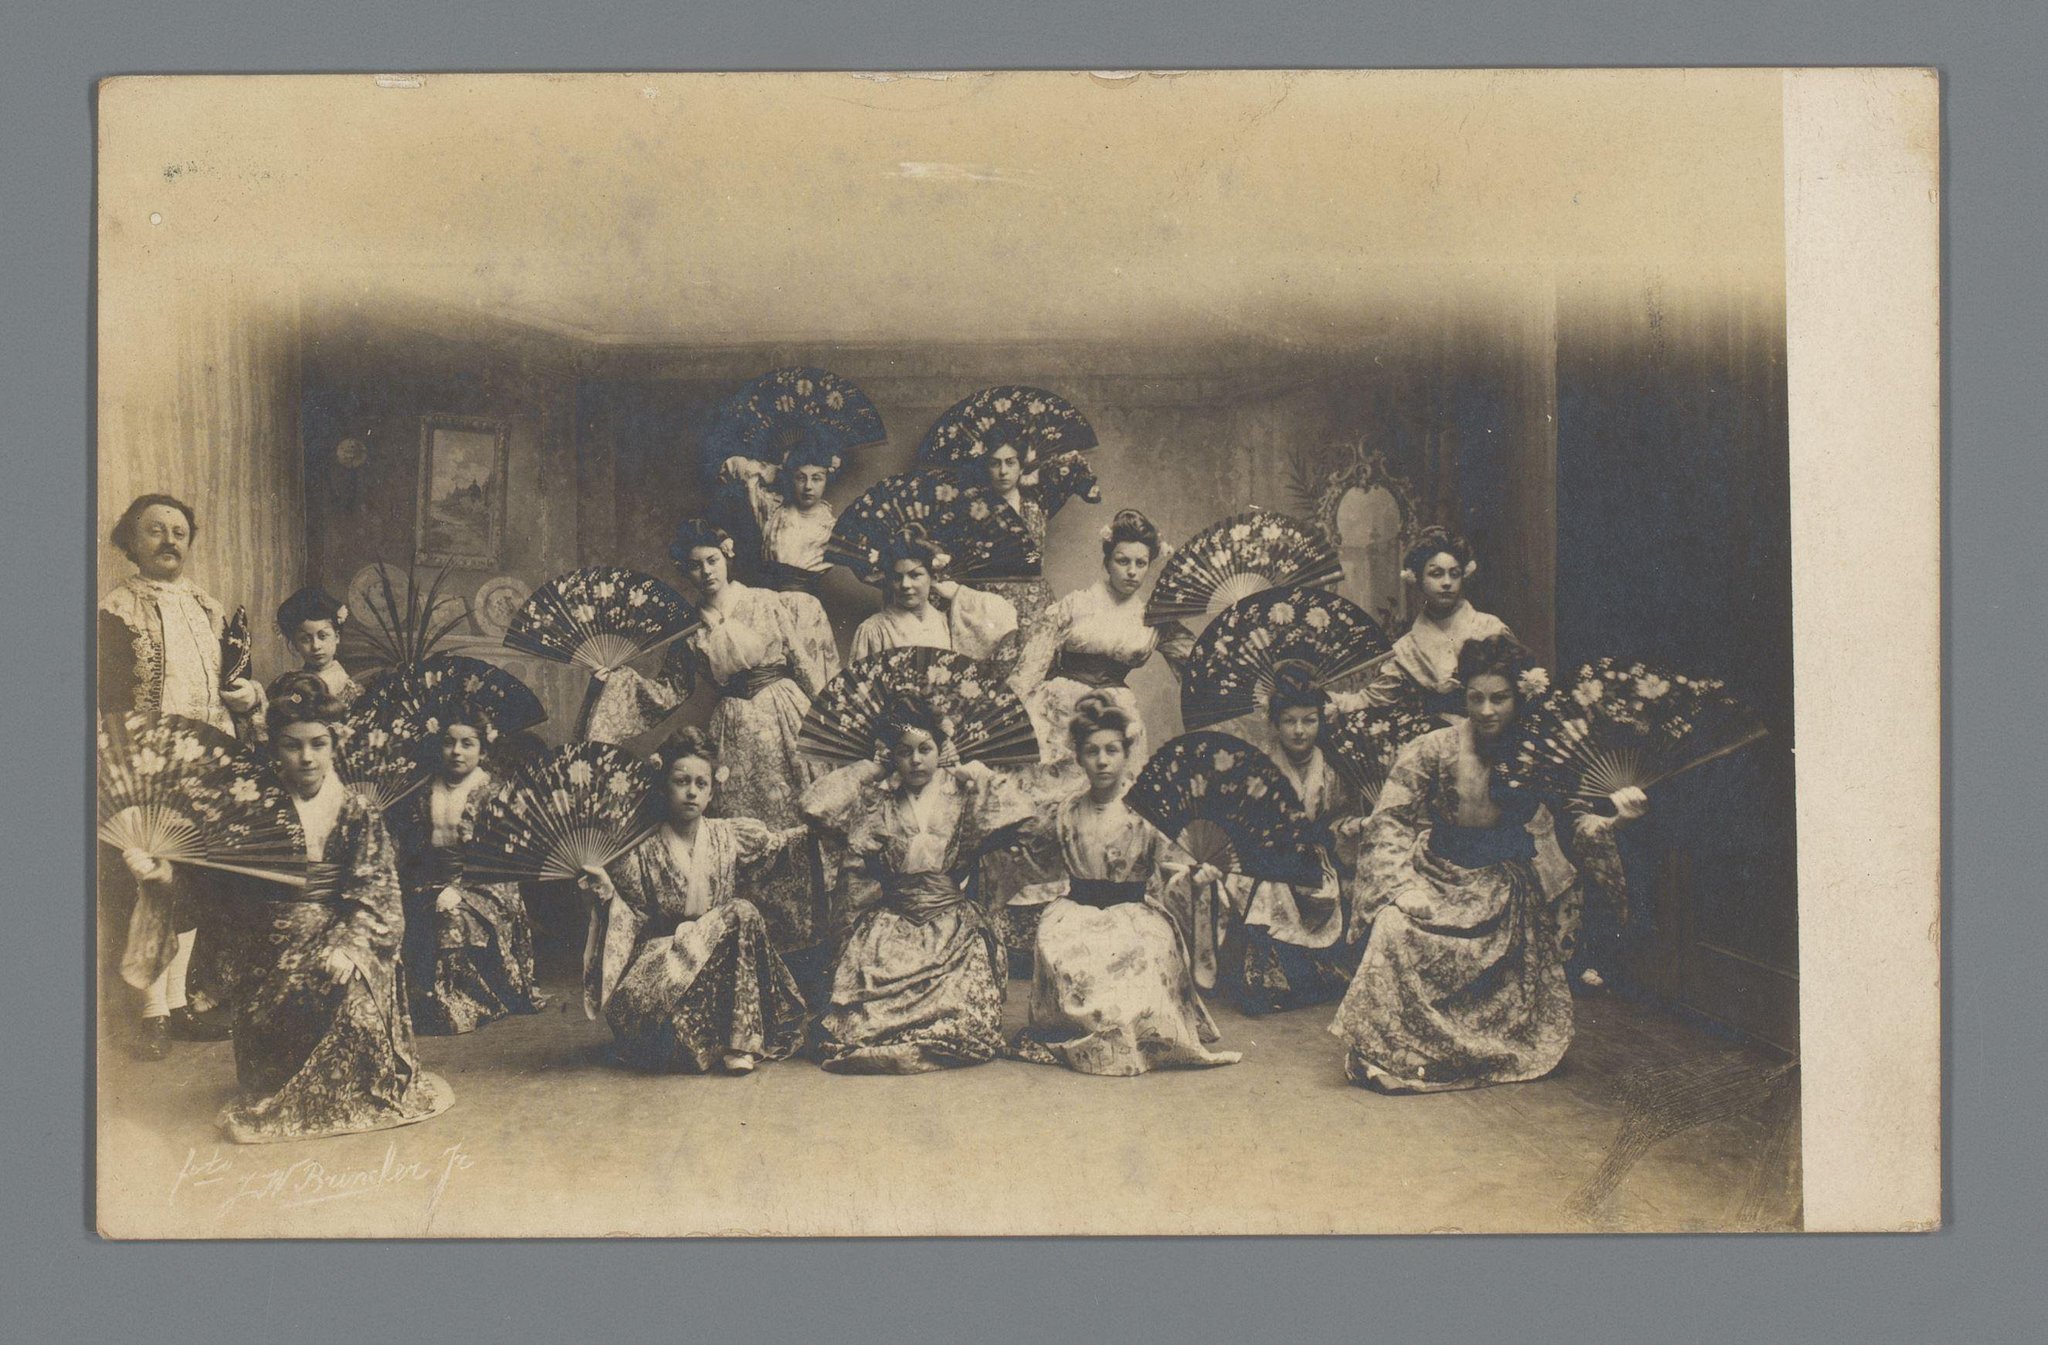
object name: photograph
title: Gezelschap in Japanse kostuums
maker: Anonymous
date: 1890-1905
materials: photographic support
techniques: gaslight paper print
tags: folk costume, regional costume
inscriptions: inscription: ‘Carte Postale sensible "VELOX"’